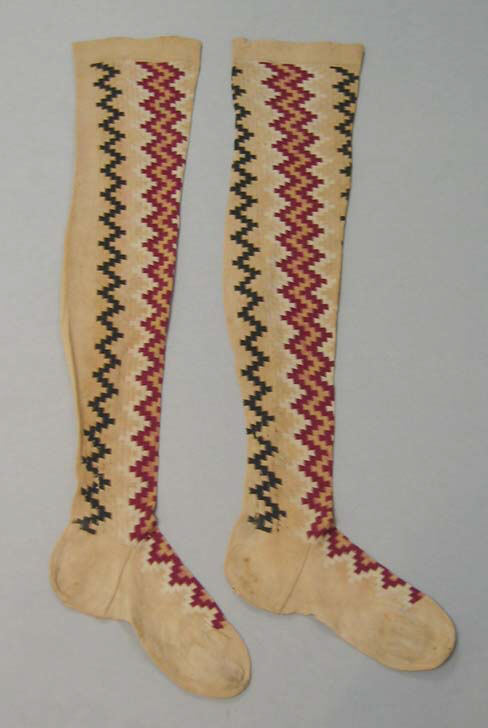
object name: stocking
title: Stockings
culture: american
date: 1801-1833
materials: cotton